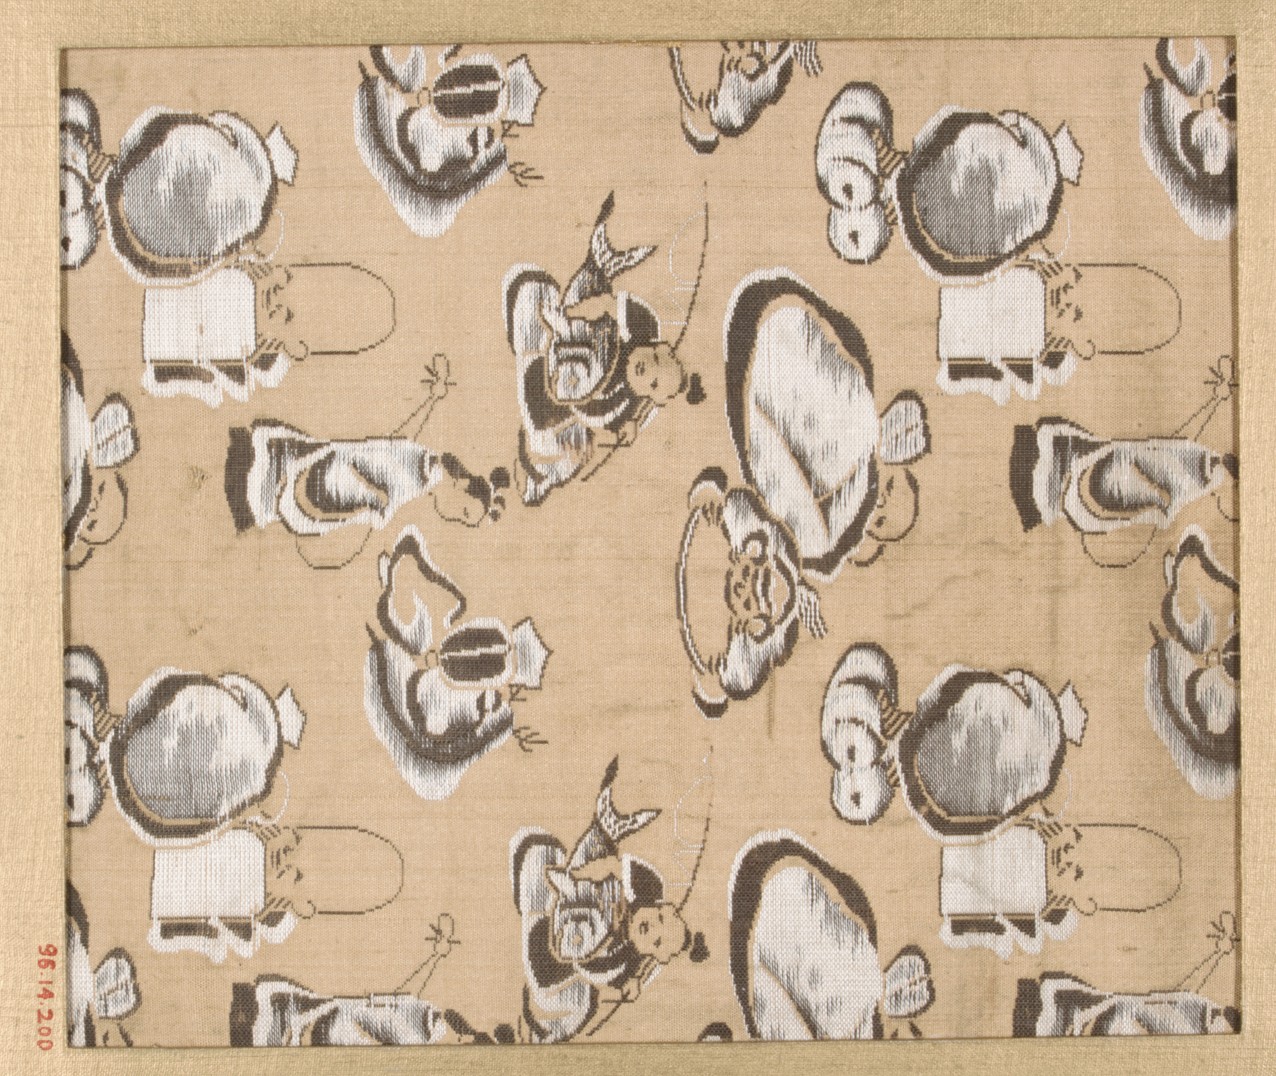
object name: piece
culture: japanese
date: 1701-1900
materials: silk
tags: human figures